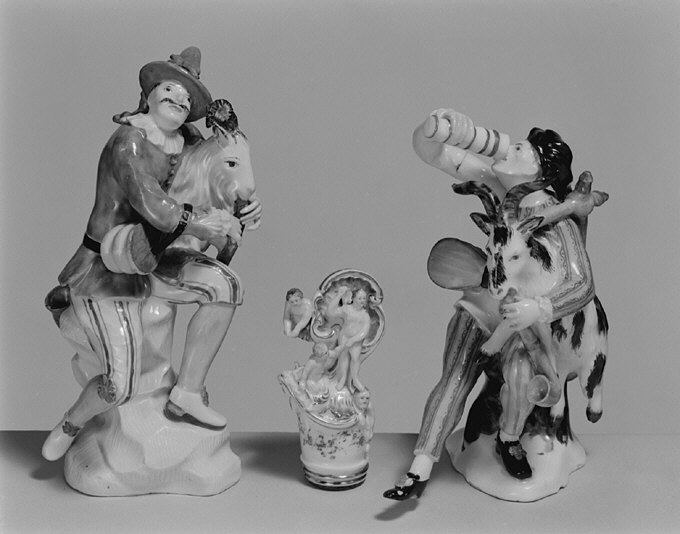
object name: group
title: Musician with goat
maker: höchst manufactory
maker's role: manufactory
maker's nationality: german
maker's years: 1746-1796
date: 1755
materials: hard paste porcelain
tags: men,goats,drinking,musicians